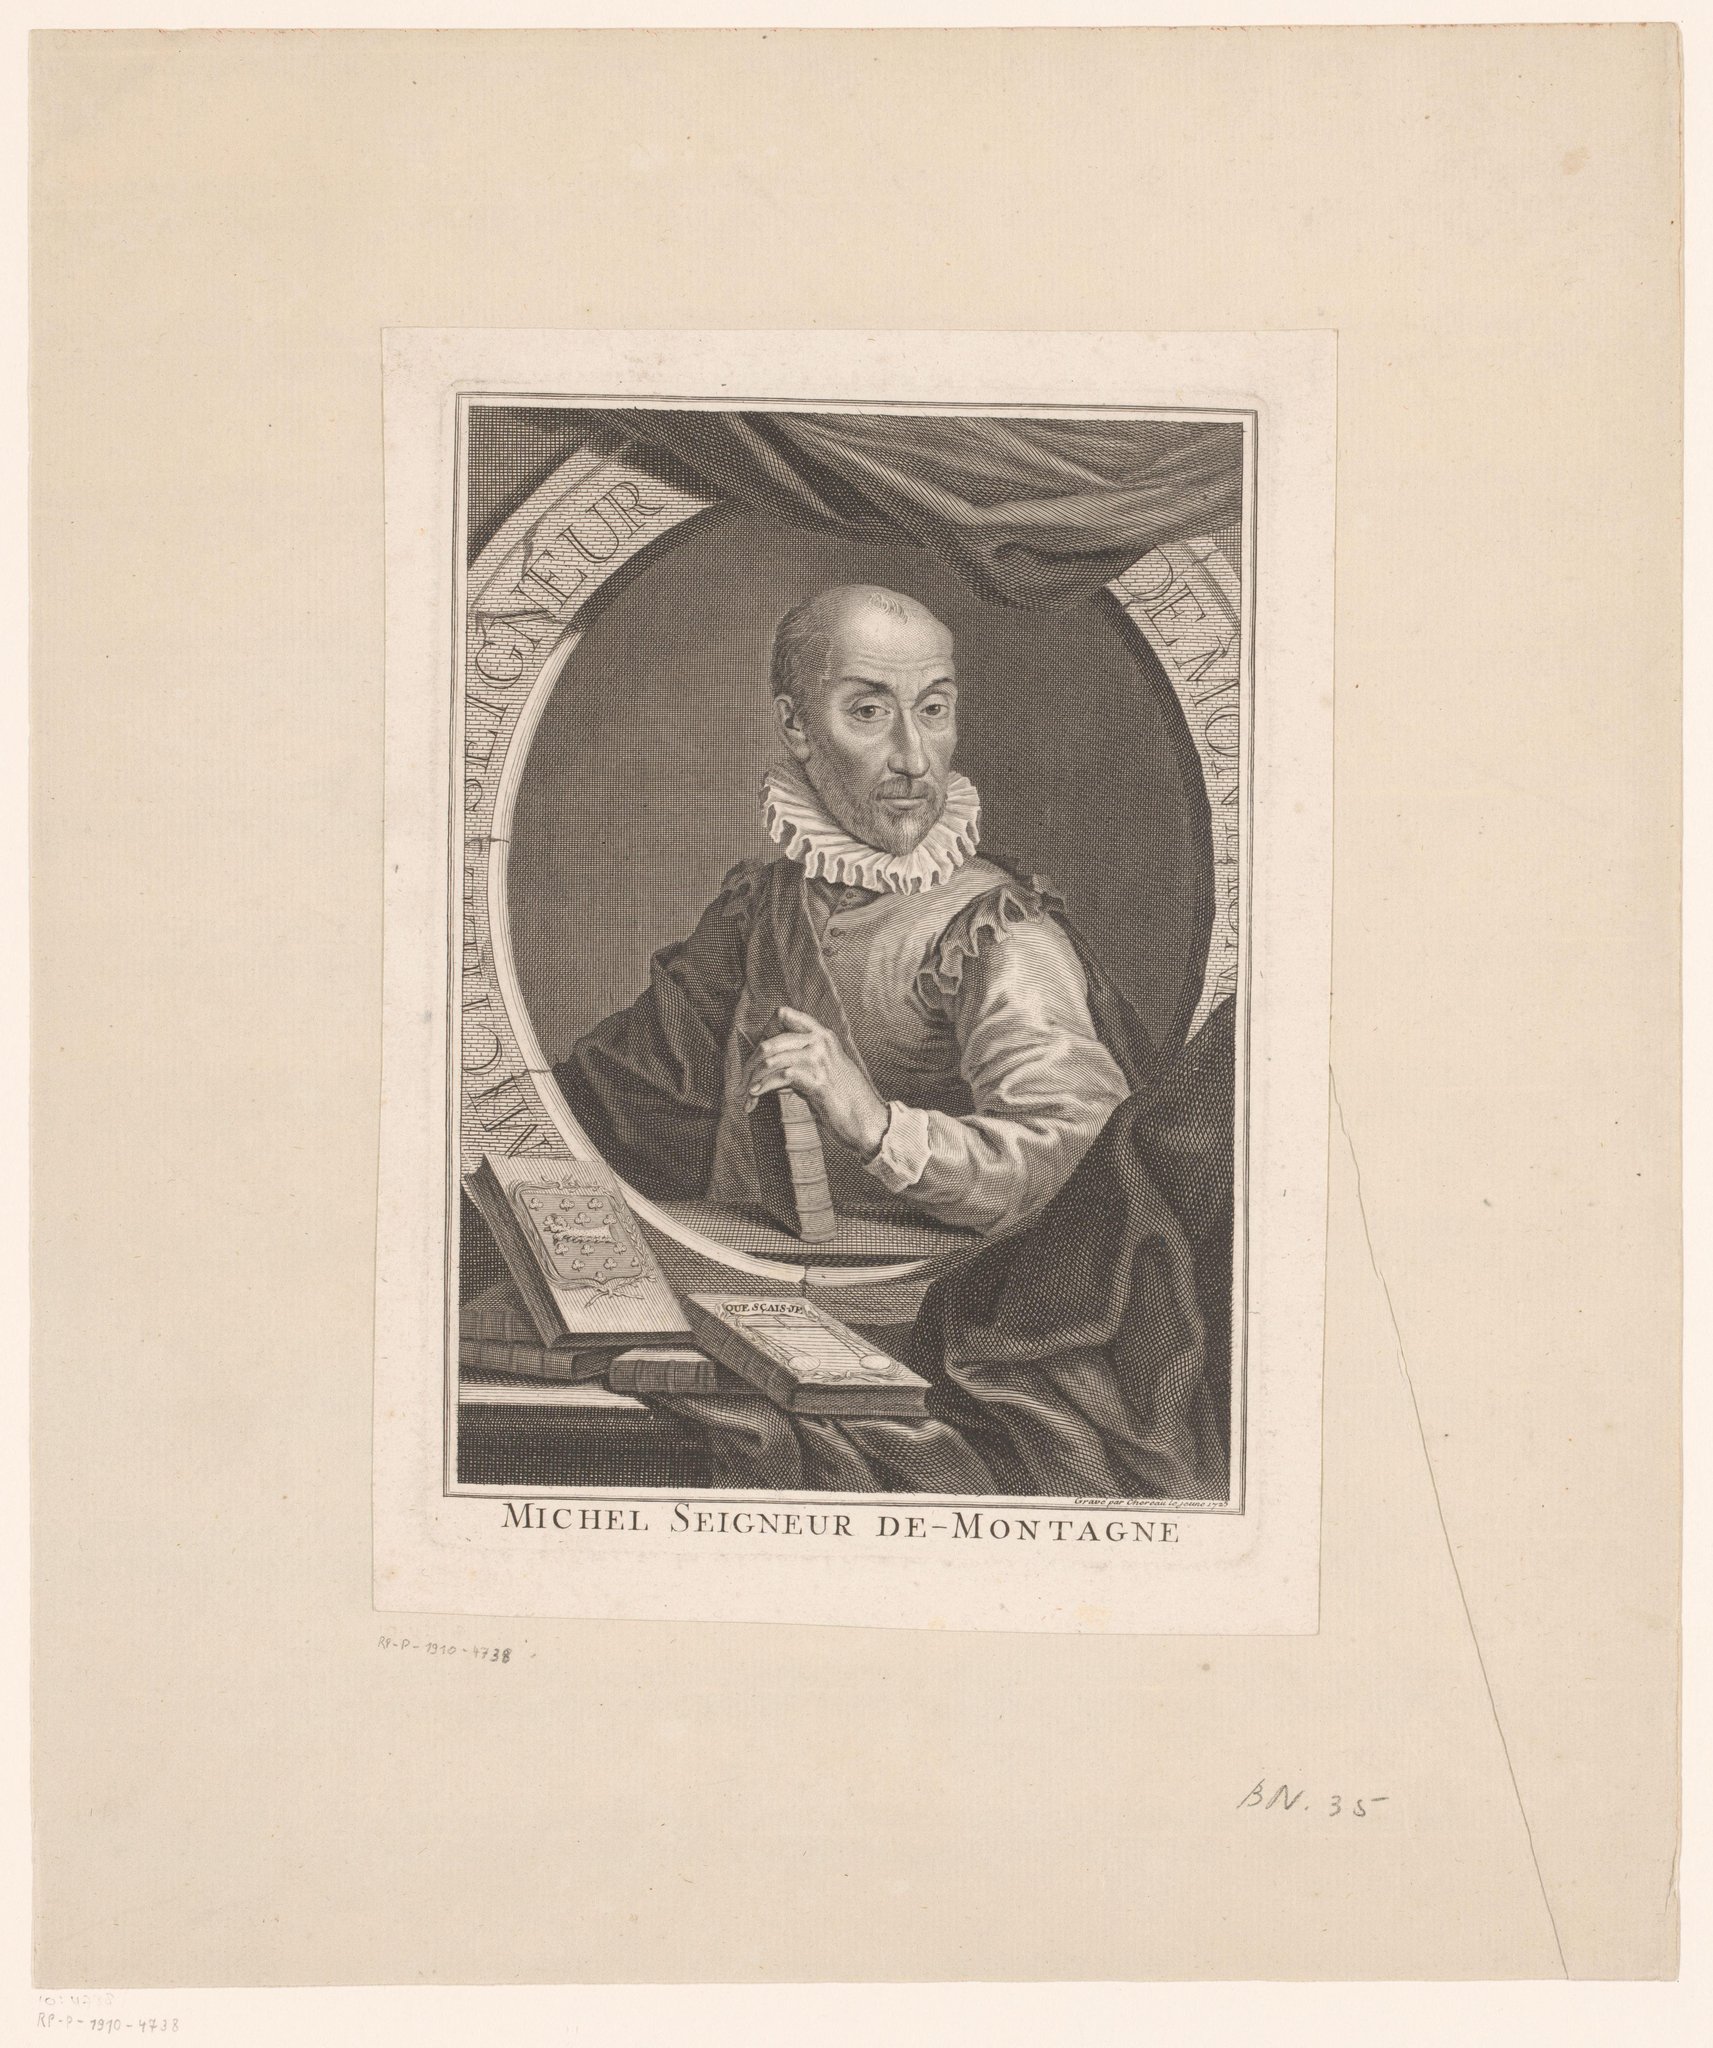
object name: print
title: Michel Seigneur de-Montagne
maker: jacques chéreau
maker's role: print maker, publisher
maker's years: 1688-1776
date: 1725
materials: paper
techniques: engraving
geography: france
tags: michel eyquem de montaigne, ornament ~ medallion, historical persons, book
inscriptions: collector's mark: Lugt 2228